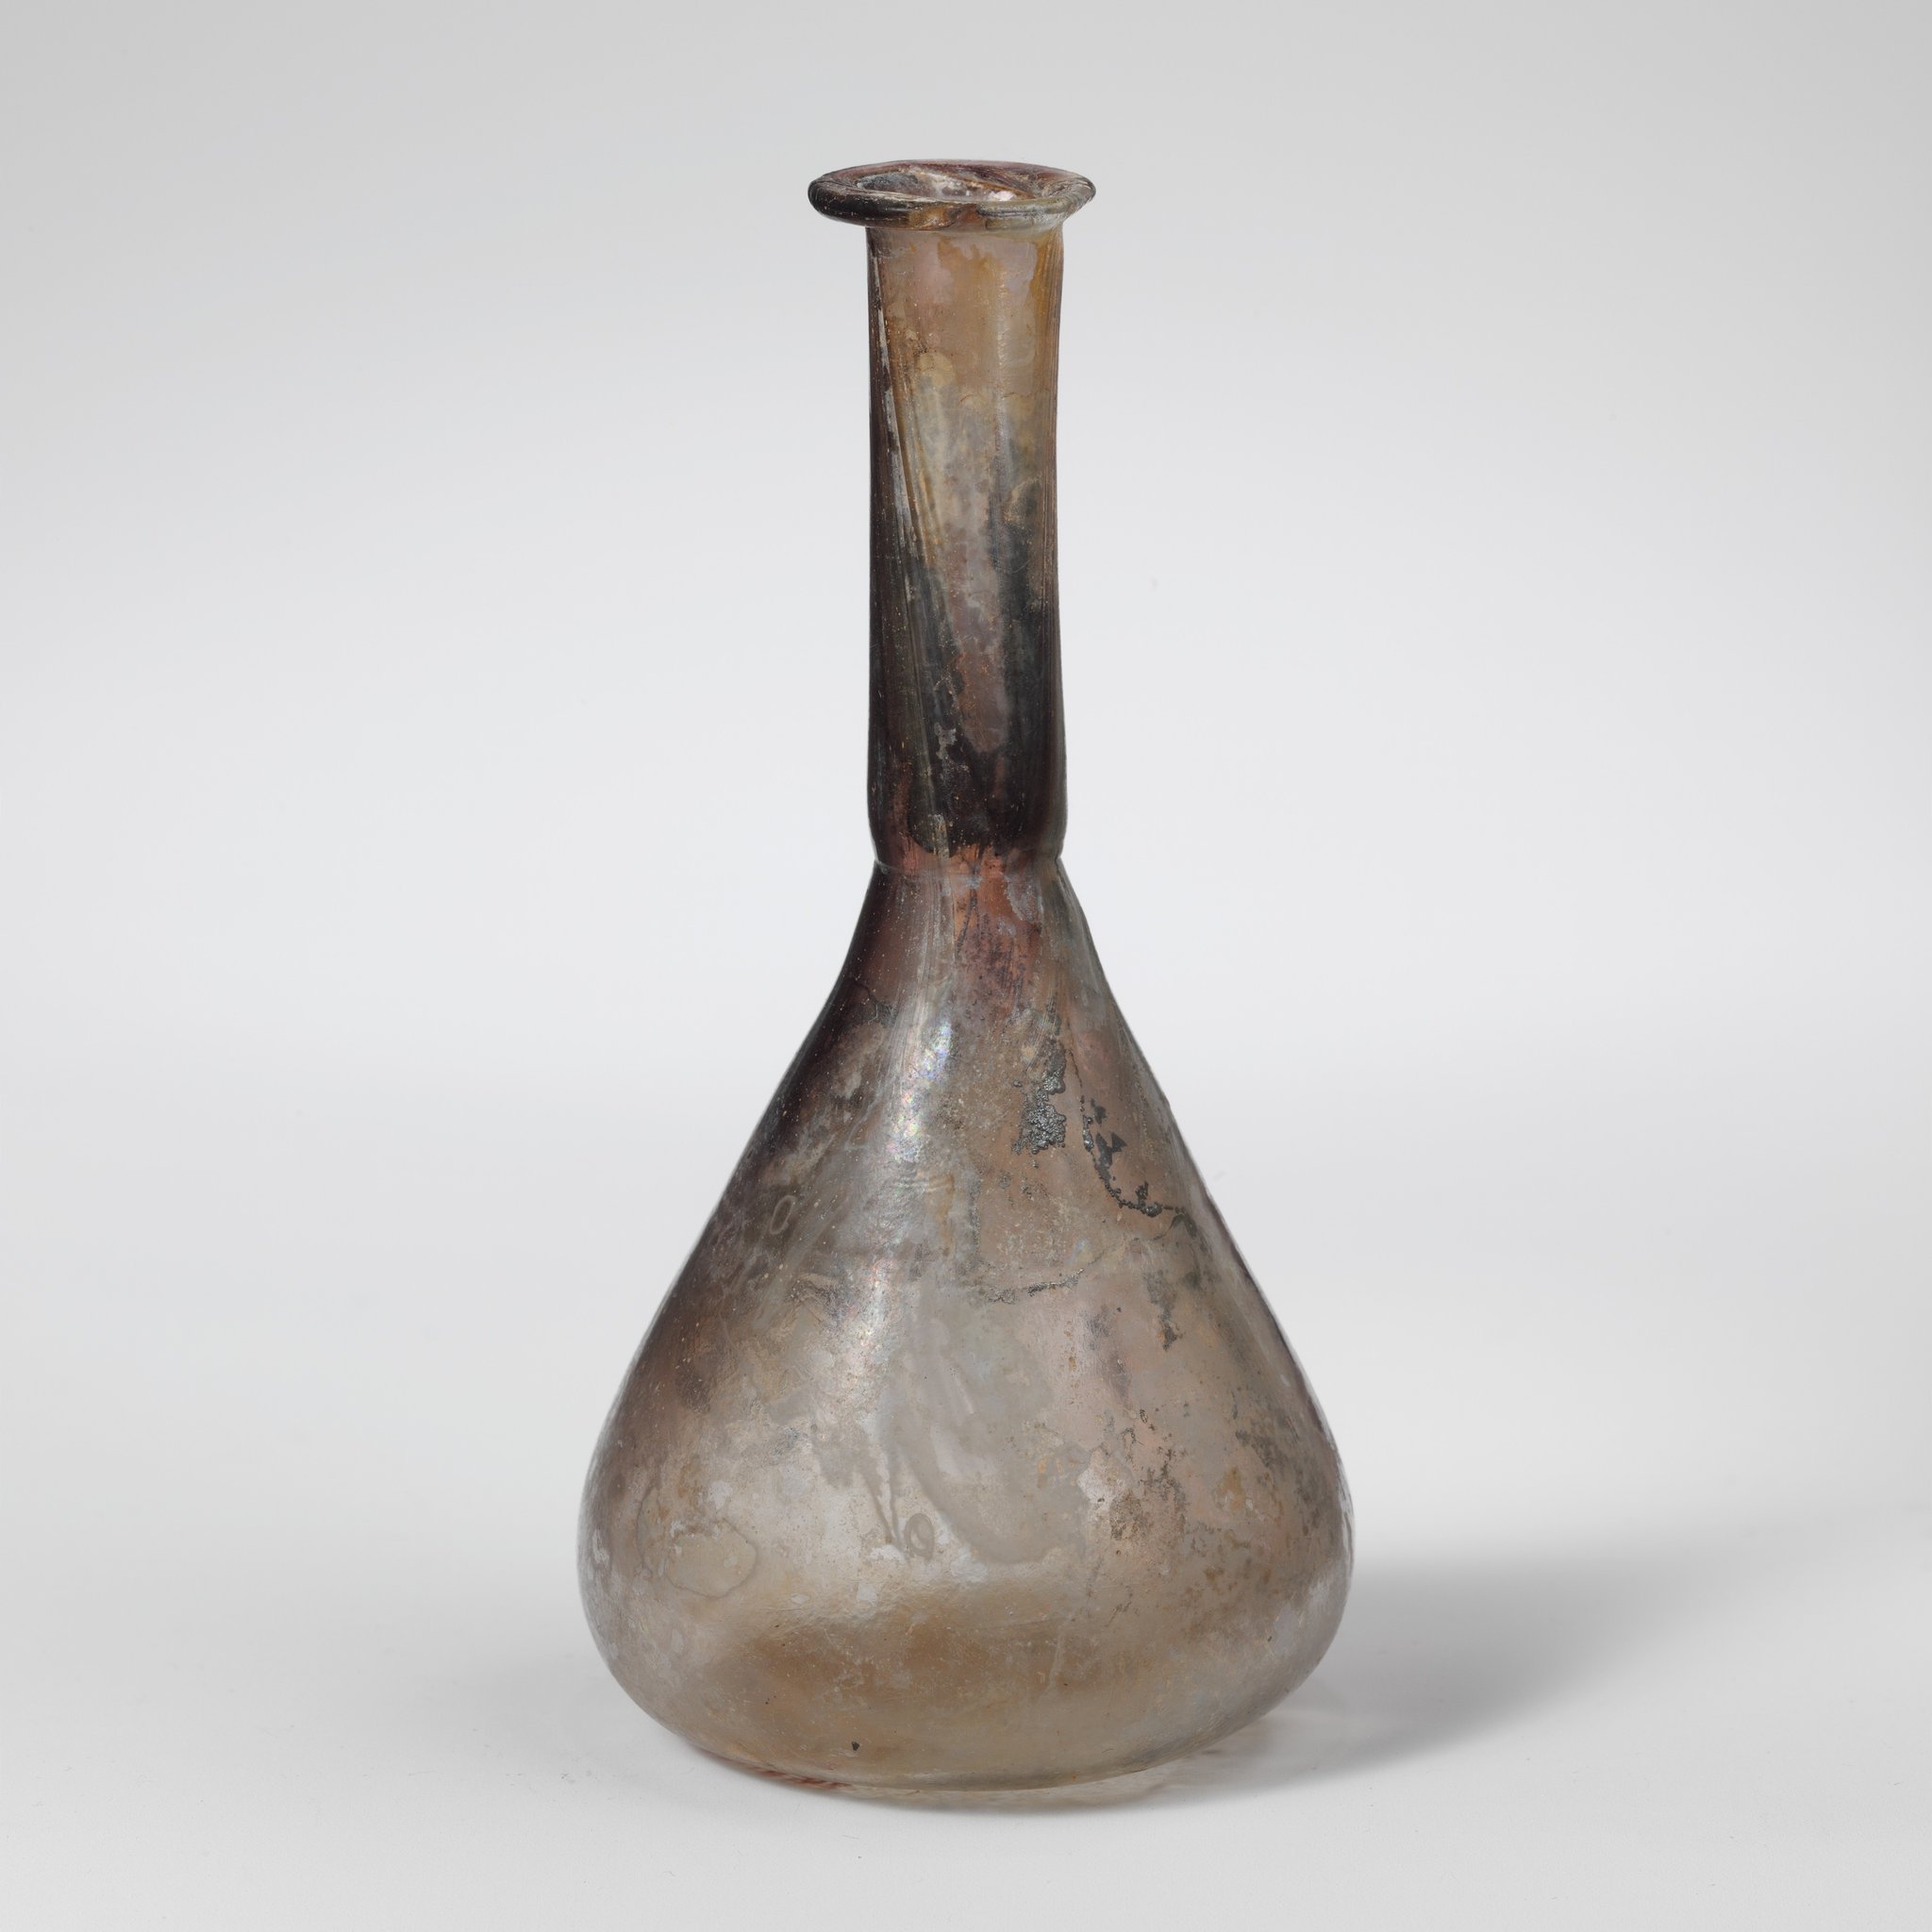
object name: perfume bottle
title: Glass perfume bottle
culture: roman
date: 1-200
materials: glass